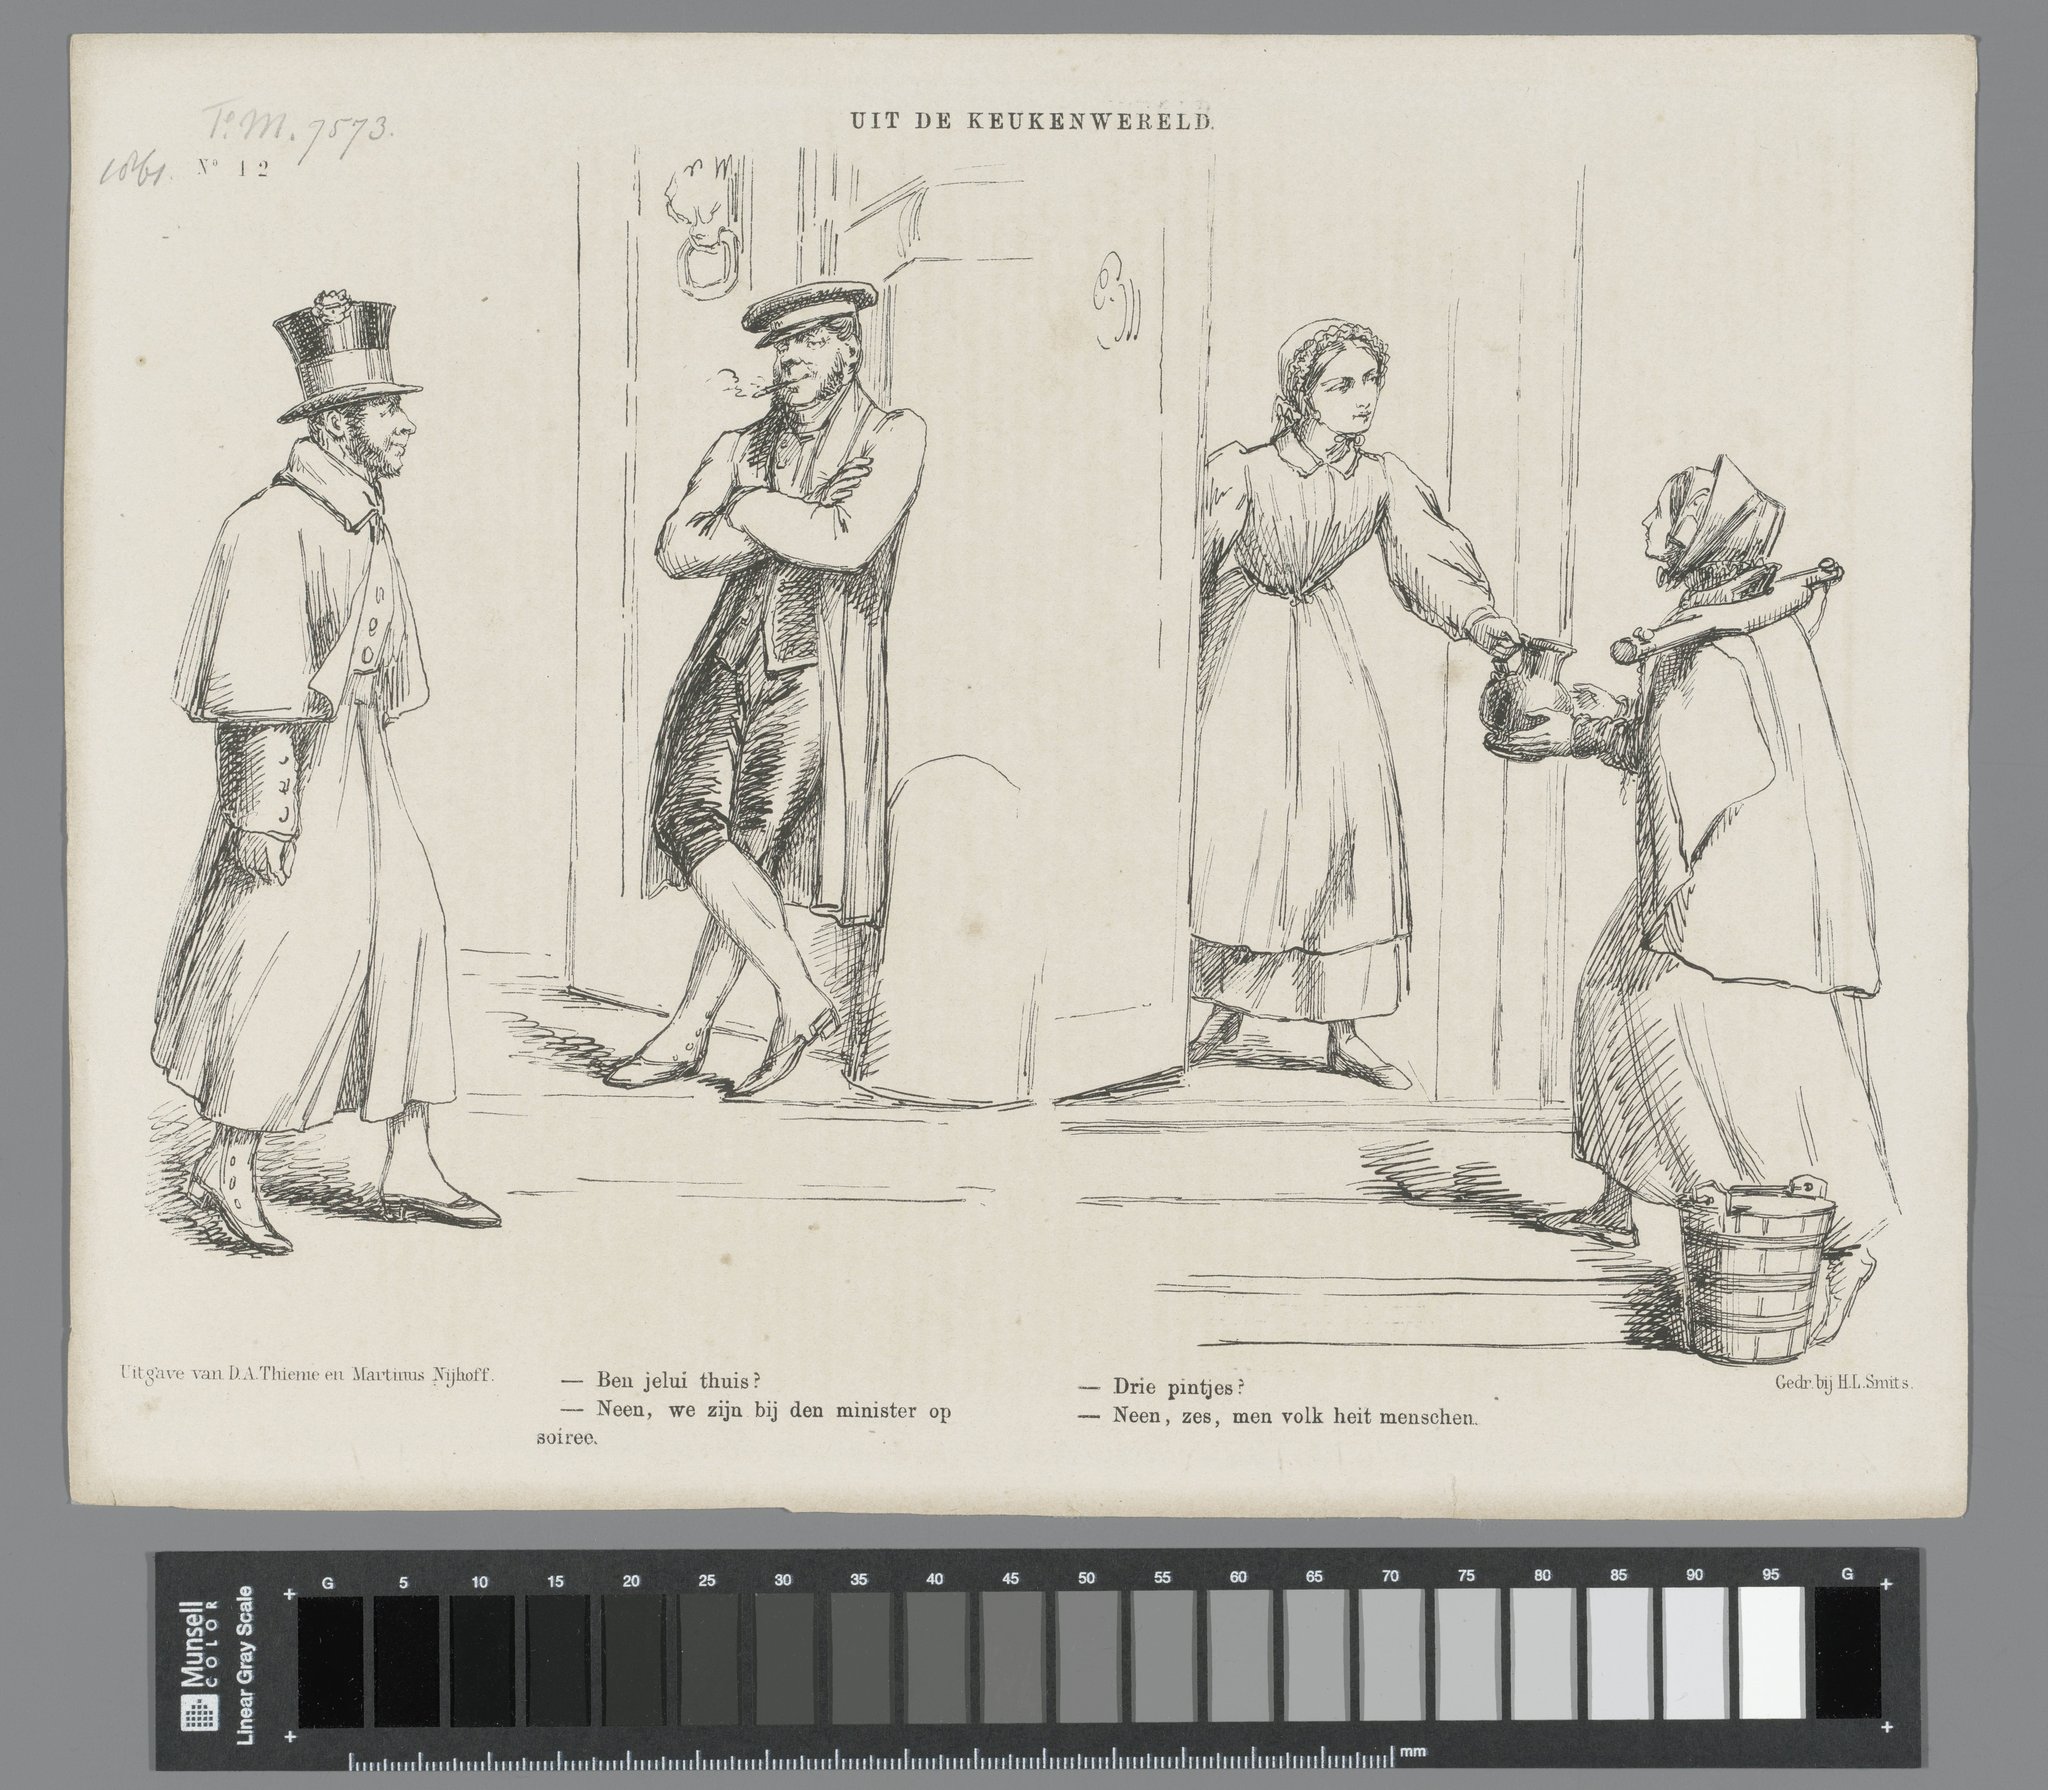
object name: cartoon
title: Spotprent met grappige uitspraken van Haagse dienstboden, 1861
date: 1861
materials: paper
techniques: lithograph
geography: arnhem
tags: house personnel, servants, the hague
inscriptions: collector's mark: Lugt 2228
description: Spotprent met grappige uitspraken van Haagse dienstboden. Plaat verschenen bij het weekblad De Nederlandsche Spectator, nr. 12, 23 maart 1861.